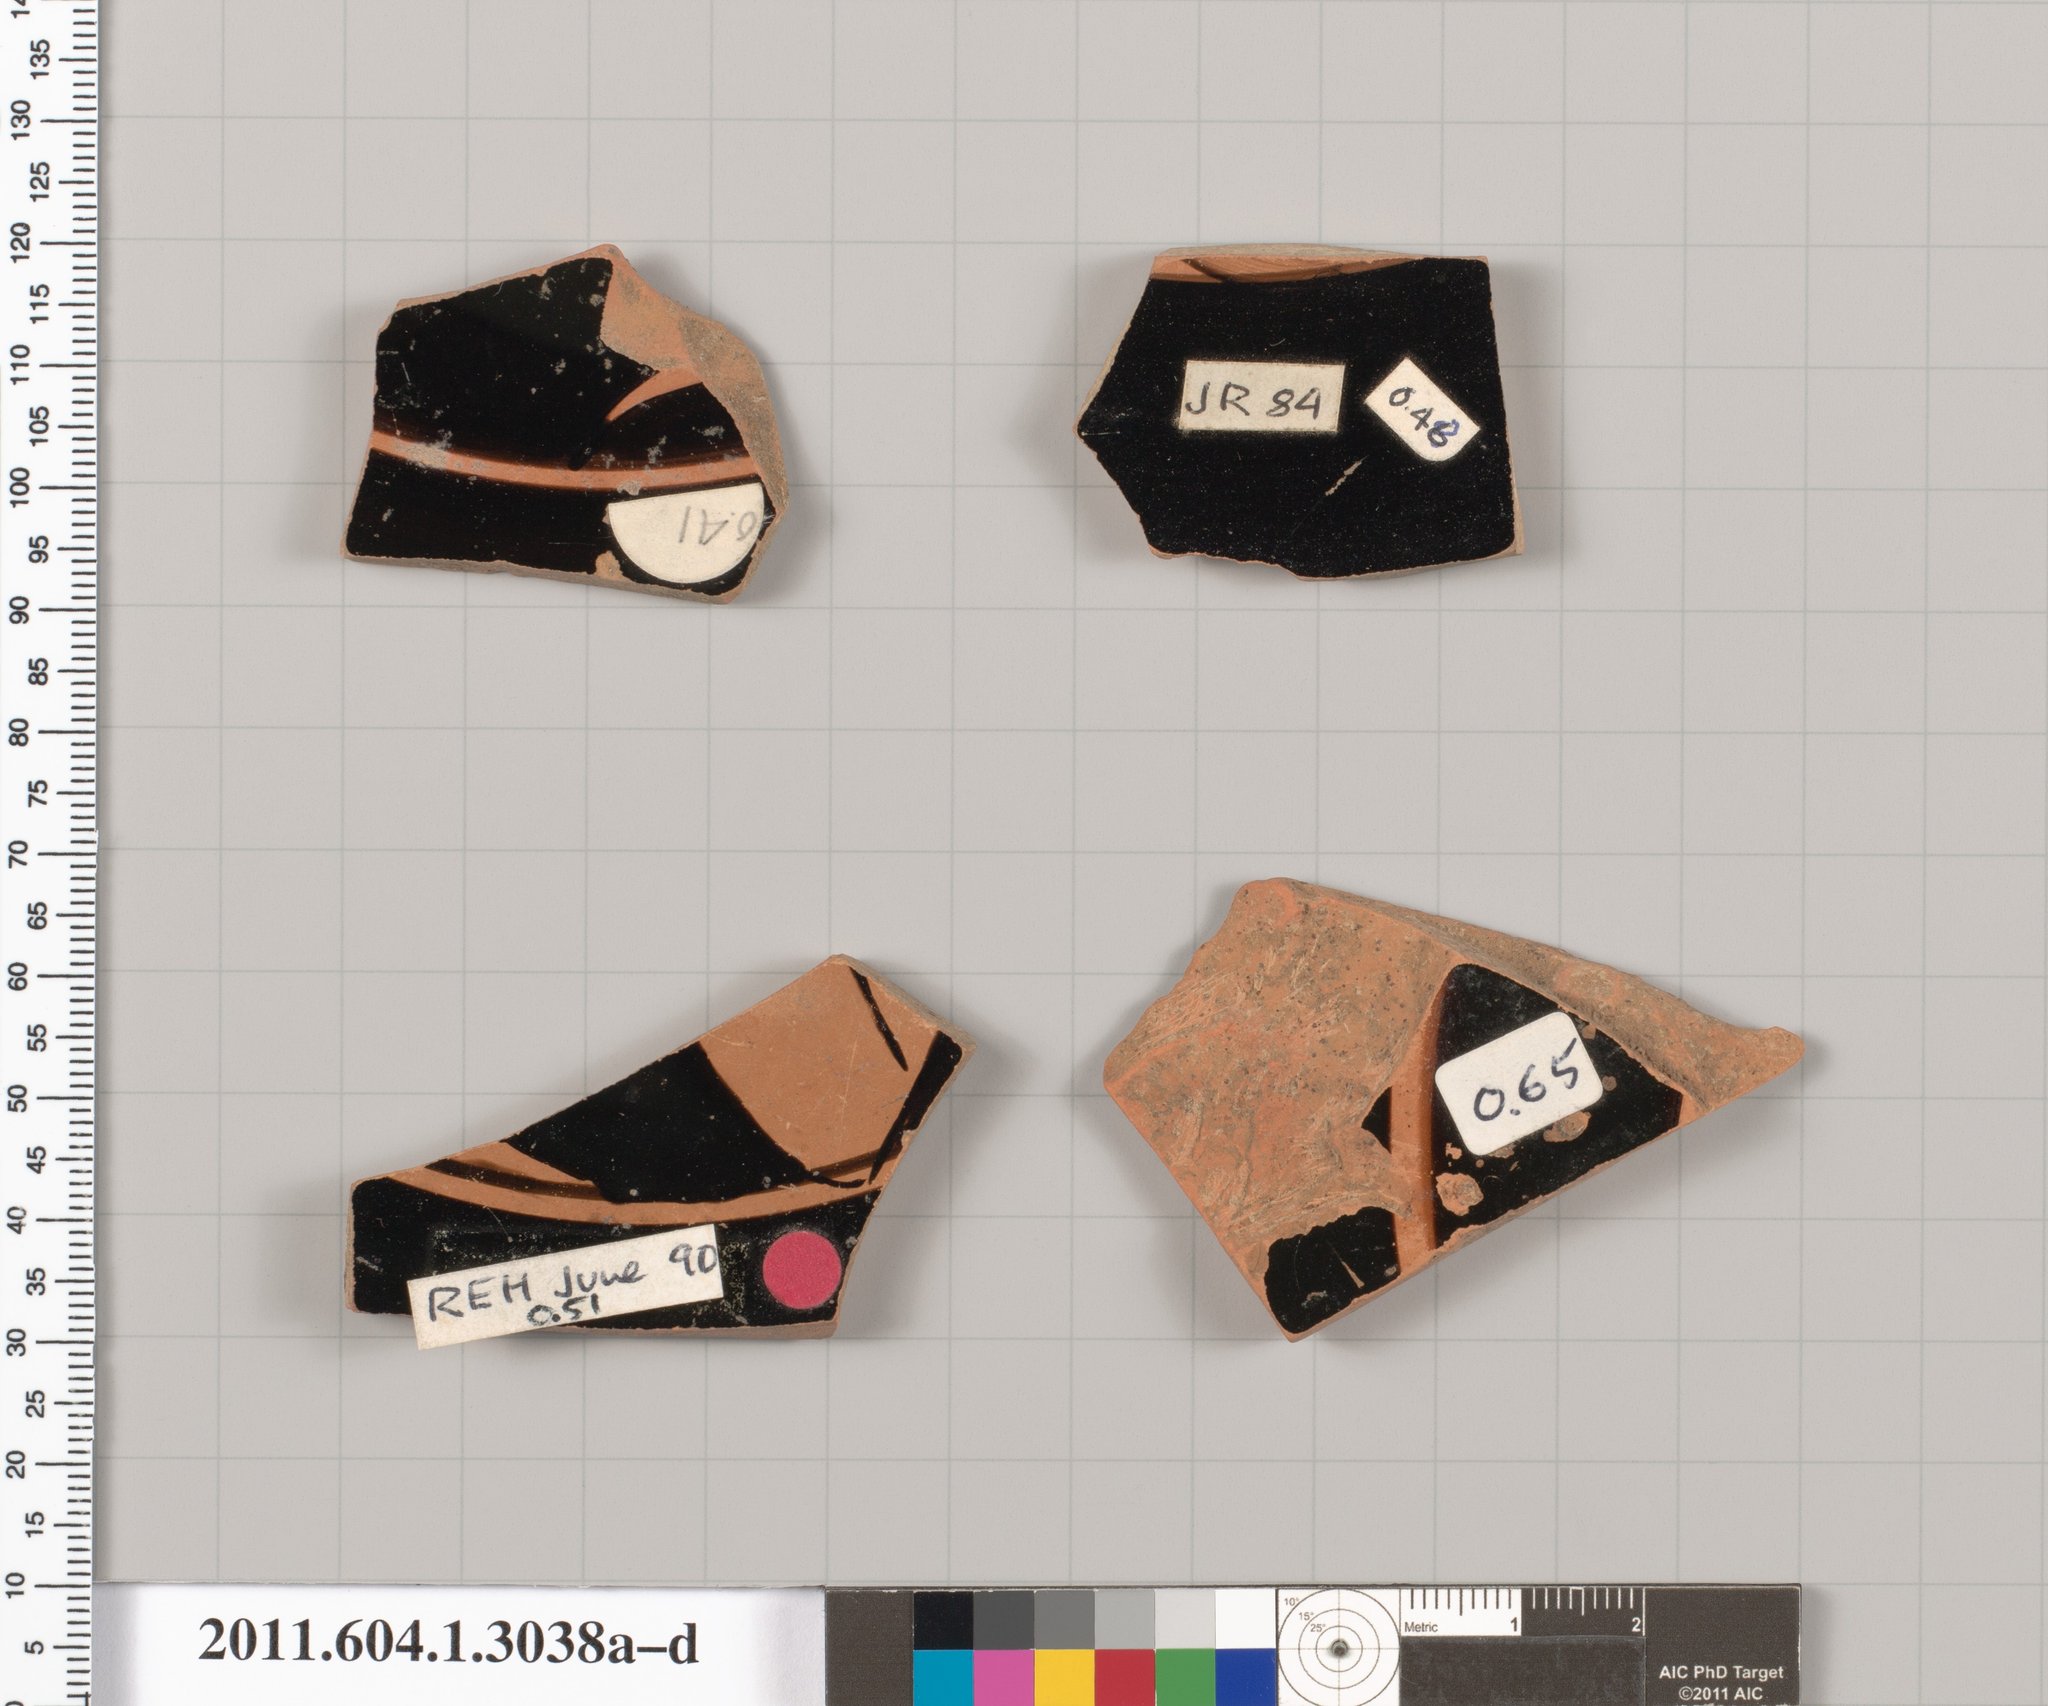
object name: kylix fragment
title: Terracotta fragments of kylikes (drinking cups)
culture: greek, attic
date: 520-490 BCE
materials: terracotta